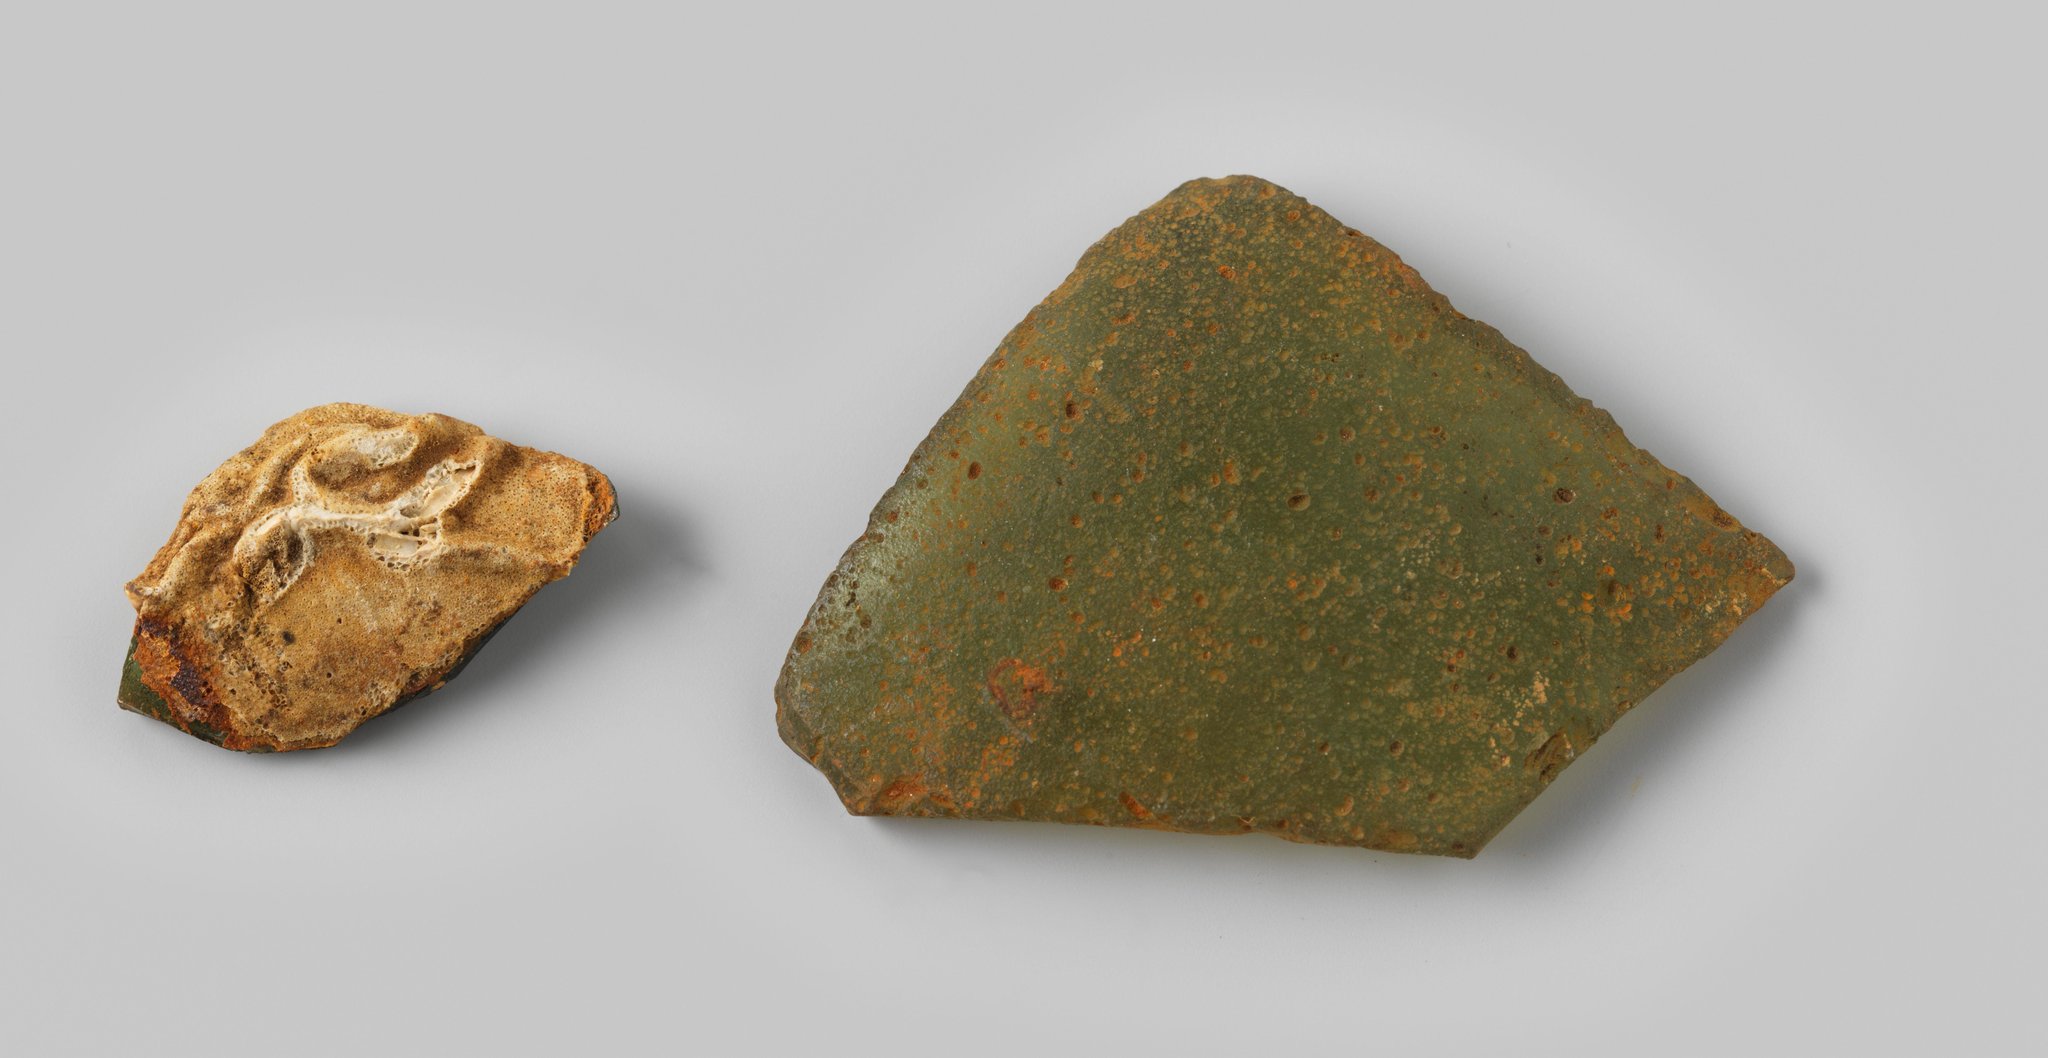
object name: wine bottle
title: Scherven van wijnflessen uit het wrak van de Oost-Indiëvaarder Hollandia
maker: Anonymous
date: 1700-1743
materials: glass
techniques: green glass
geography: netherlands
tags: verenigde oostindische compagnie, hollandia (schip), annet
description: Typologically not identifiable, belly, fragment.